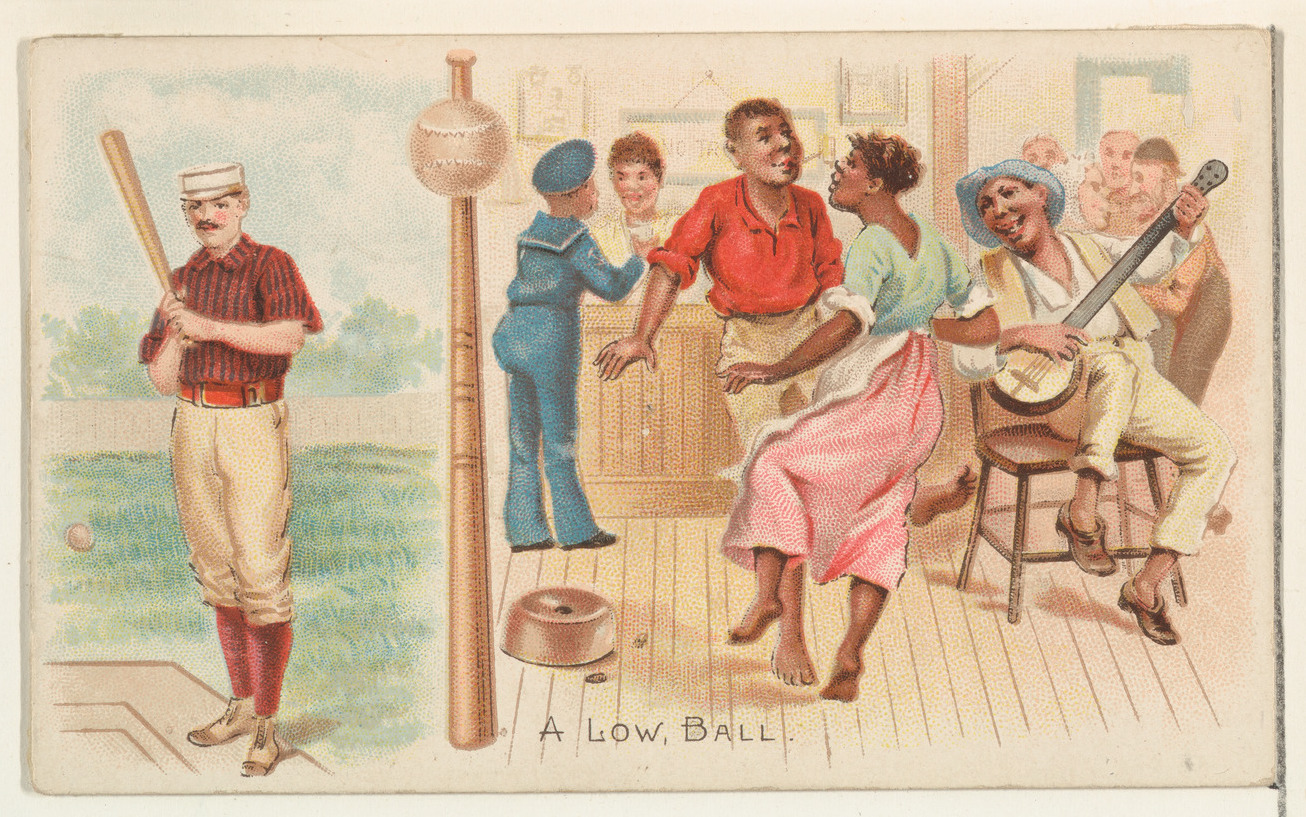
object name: print, baseball card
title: A Low Ball, from the Talk of the Diamond set (N135) issued by Duke Sons & Co., a branch of the American Tobacco Company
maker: w. duke, sons & co.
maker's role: publisher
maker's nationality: american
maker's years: 1870-1920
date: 1888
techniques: color lithograph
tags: men,women,dancing,baseball